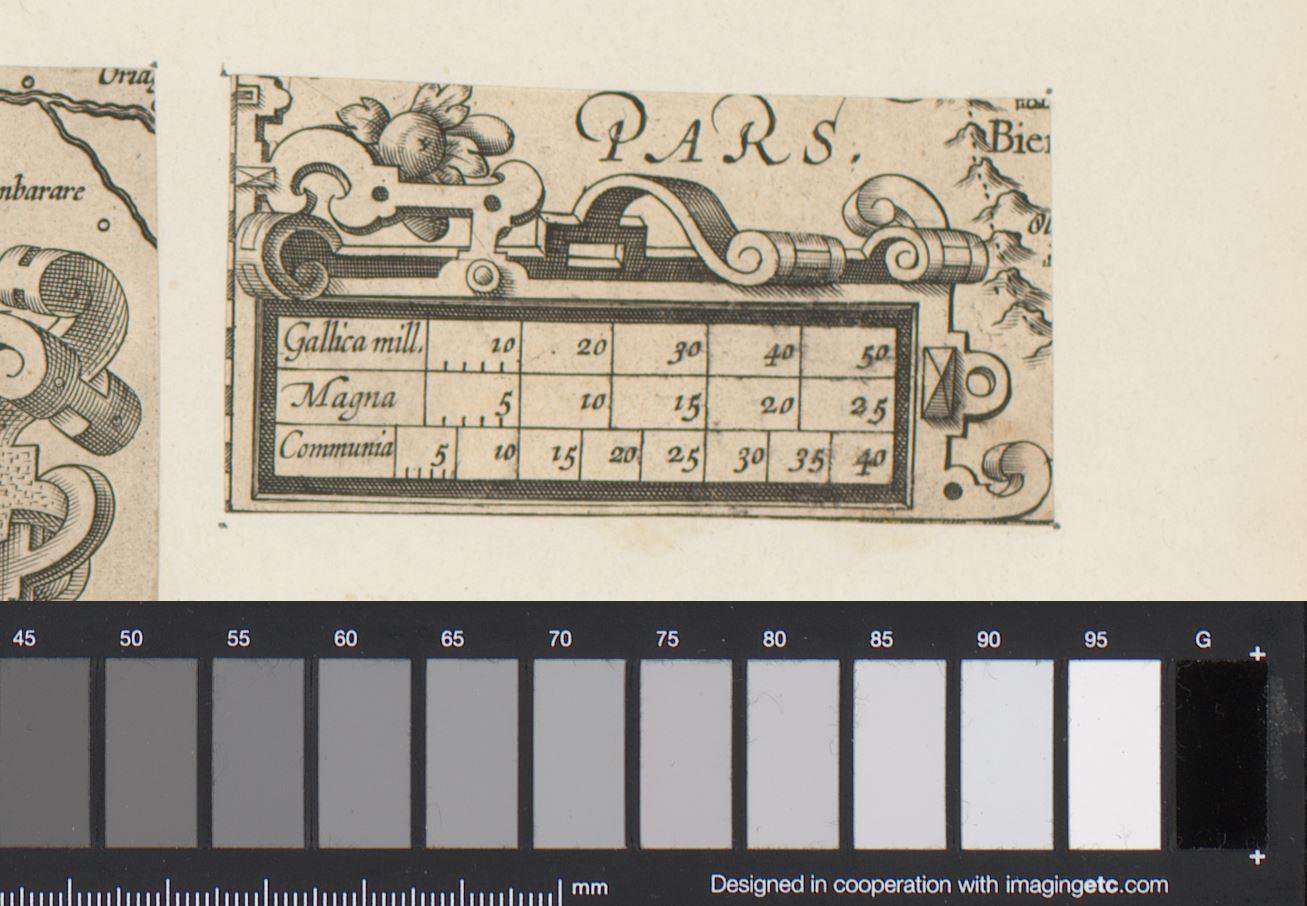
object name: ornament print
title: Gallia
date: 1606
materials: paper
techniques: engraving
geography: antwerp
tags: fruits and vegetables ~ ornament, scrollwork, strapwork ~ ornament, ornament ~ cartouche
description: Hoekcartouche met rolwerk en drie schaalstokken. De cartouche is een fragment van een kaart van Frankrijk. De prent maakt deel uit van een album.